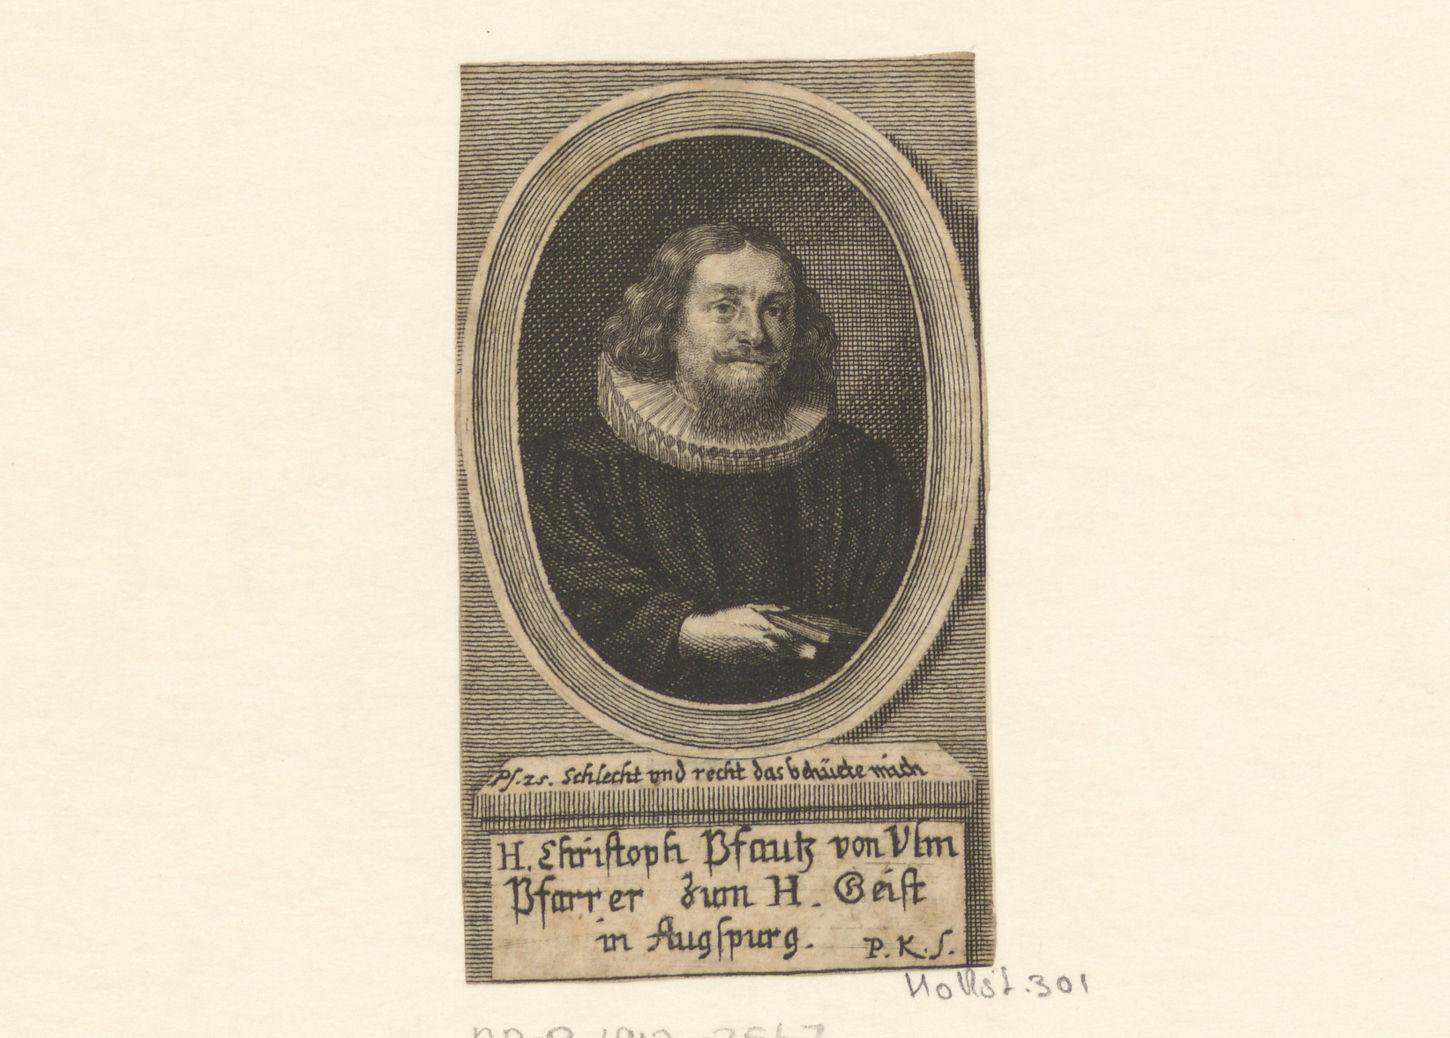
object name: print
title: Portret van Christoph Pfautz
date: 1638-1693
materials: paper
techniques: engraving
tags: theologian, historical persons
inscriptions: collector's mark: Lugt 2228